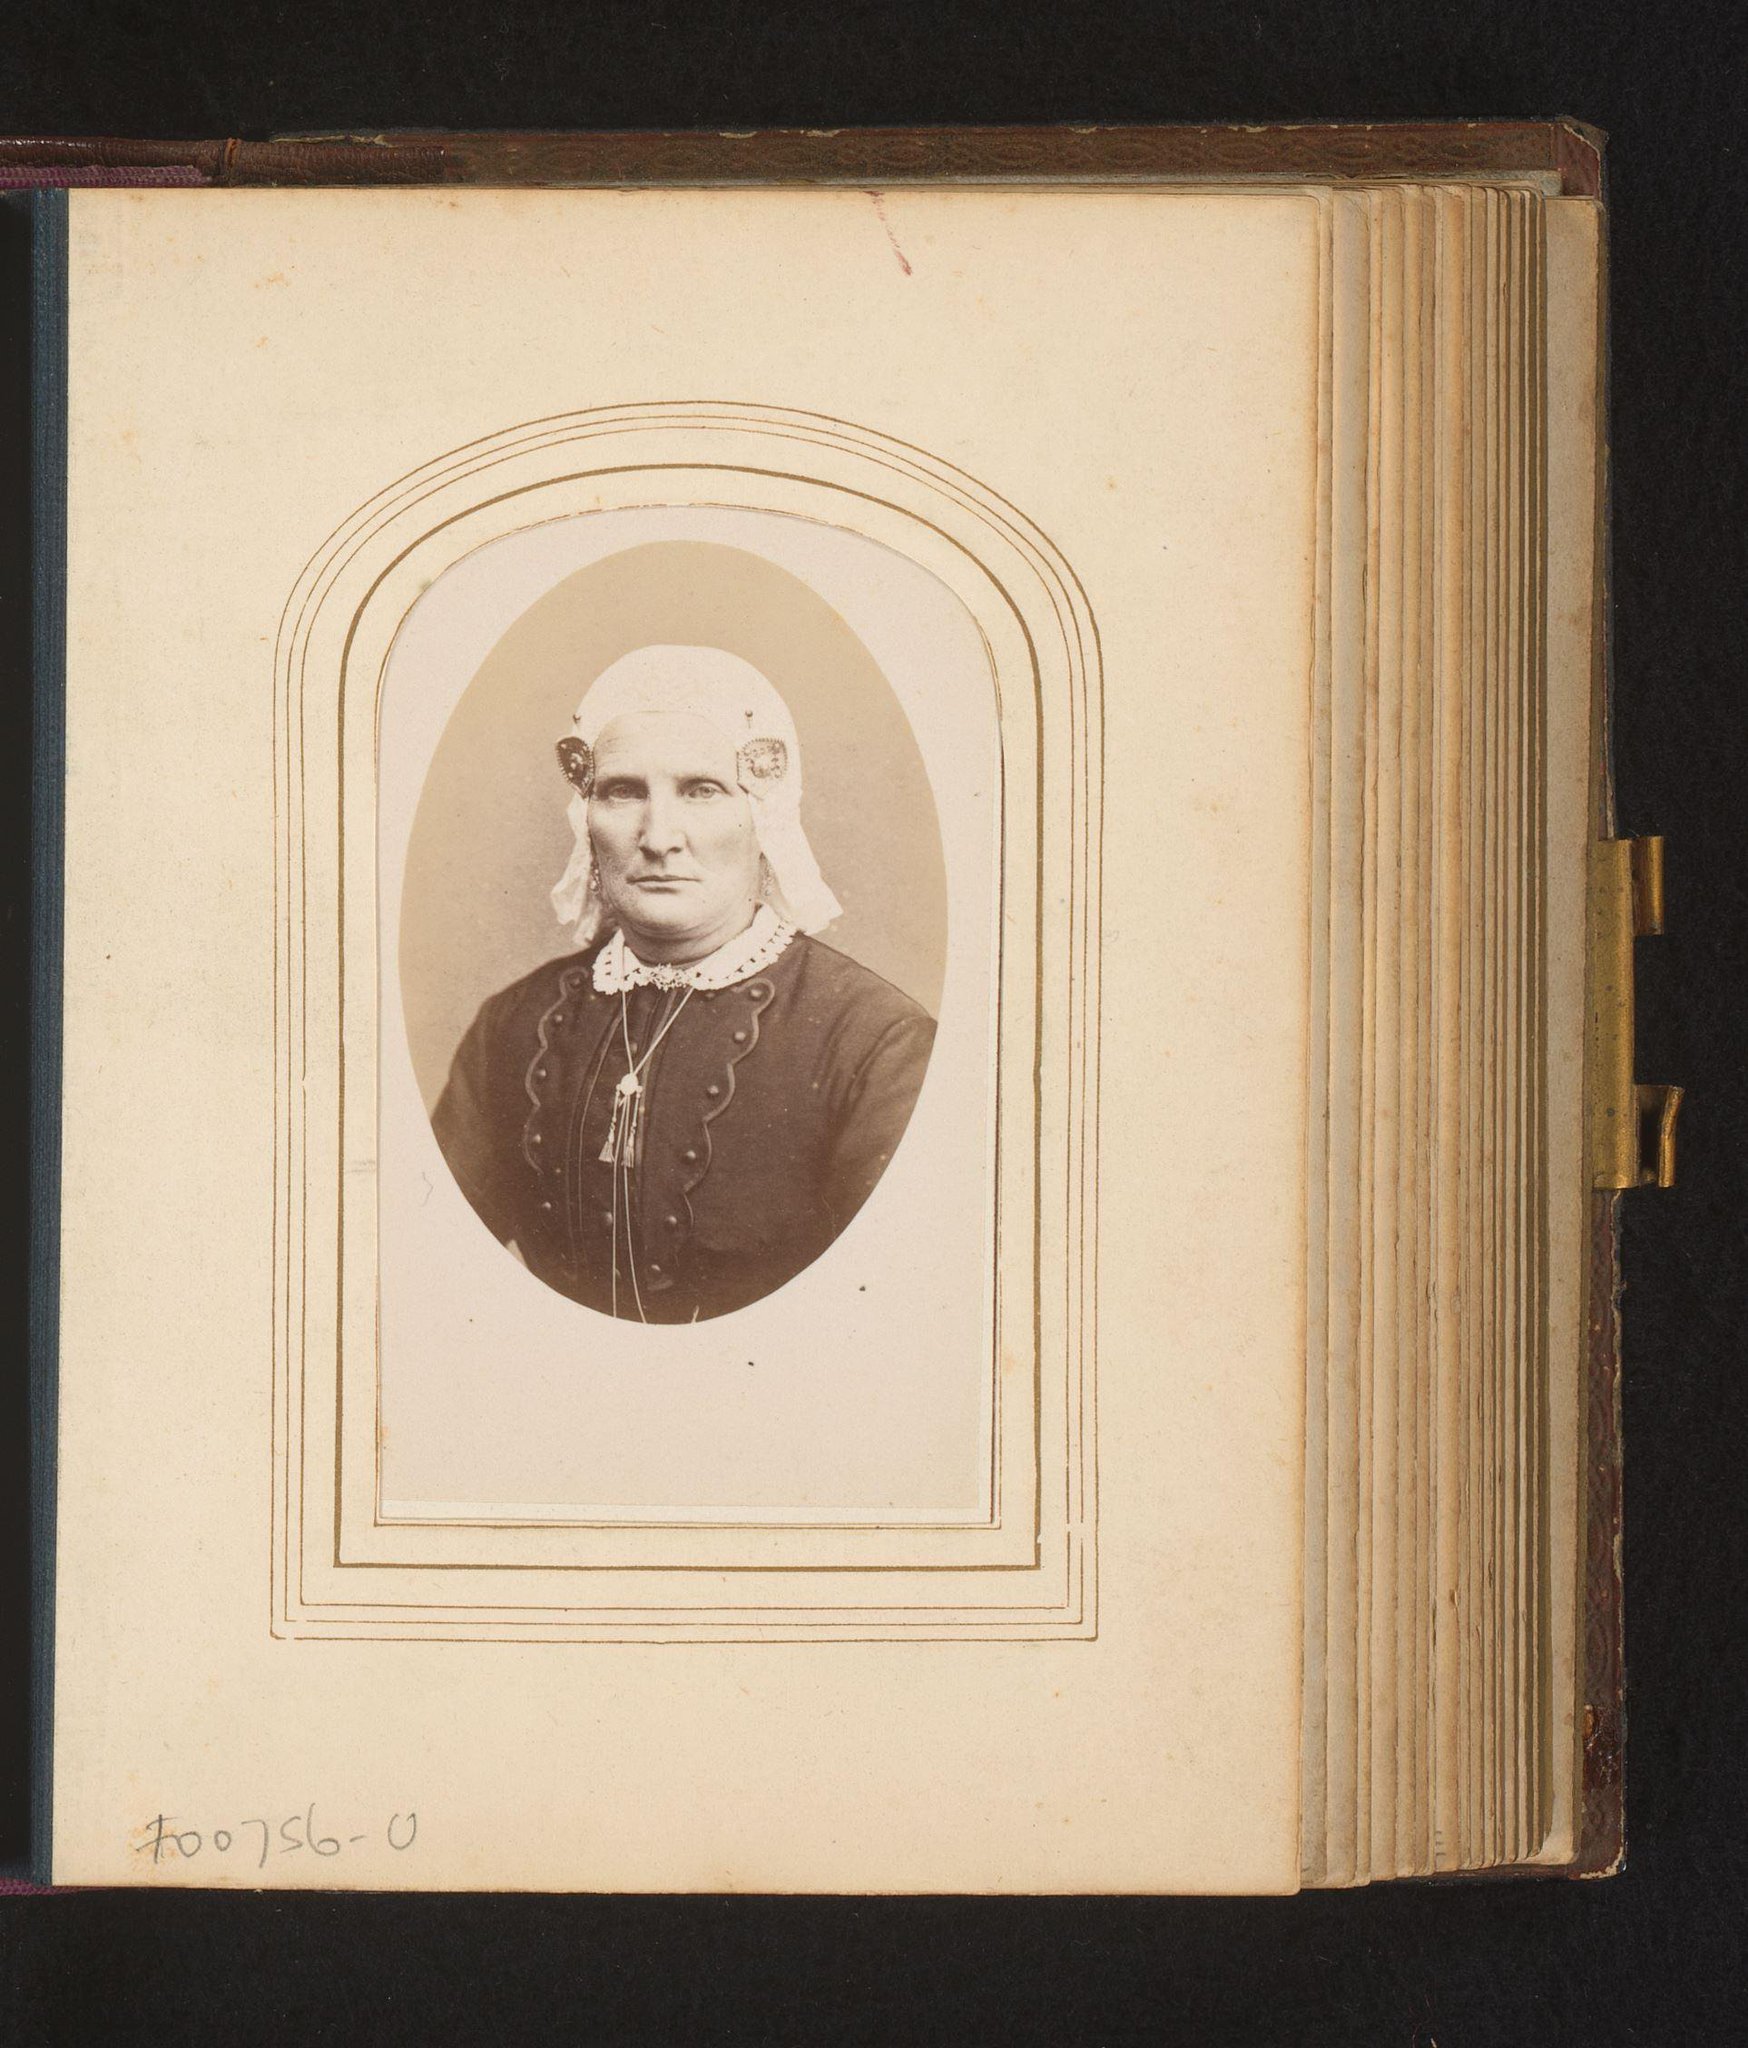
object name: carte de visite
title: Portret van een vrouw met witte klederdrachtmuts en halsketting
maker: johannes wilhelmus karsses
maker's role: draughtsman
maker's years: 1841-1875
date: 1856-1875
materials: cardboard, photographic support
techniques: albumen print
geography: groningen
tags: historical persons - bb - woman, head-gear: cap, folk costume, regional costume, necklace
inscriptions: inscription: ‘J. W. Karsses/ Kunstschilder en Photograaf/ Buiten de Heerepoort/ O. Z. Heereweg U 513/ te/ Groningen./ Voor nabestelling blijft deze plaat/ bewaard.’